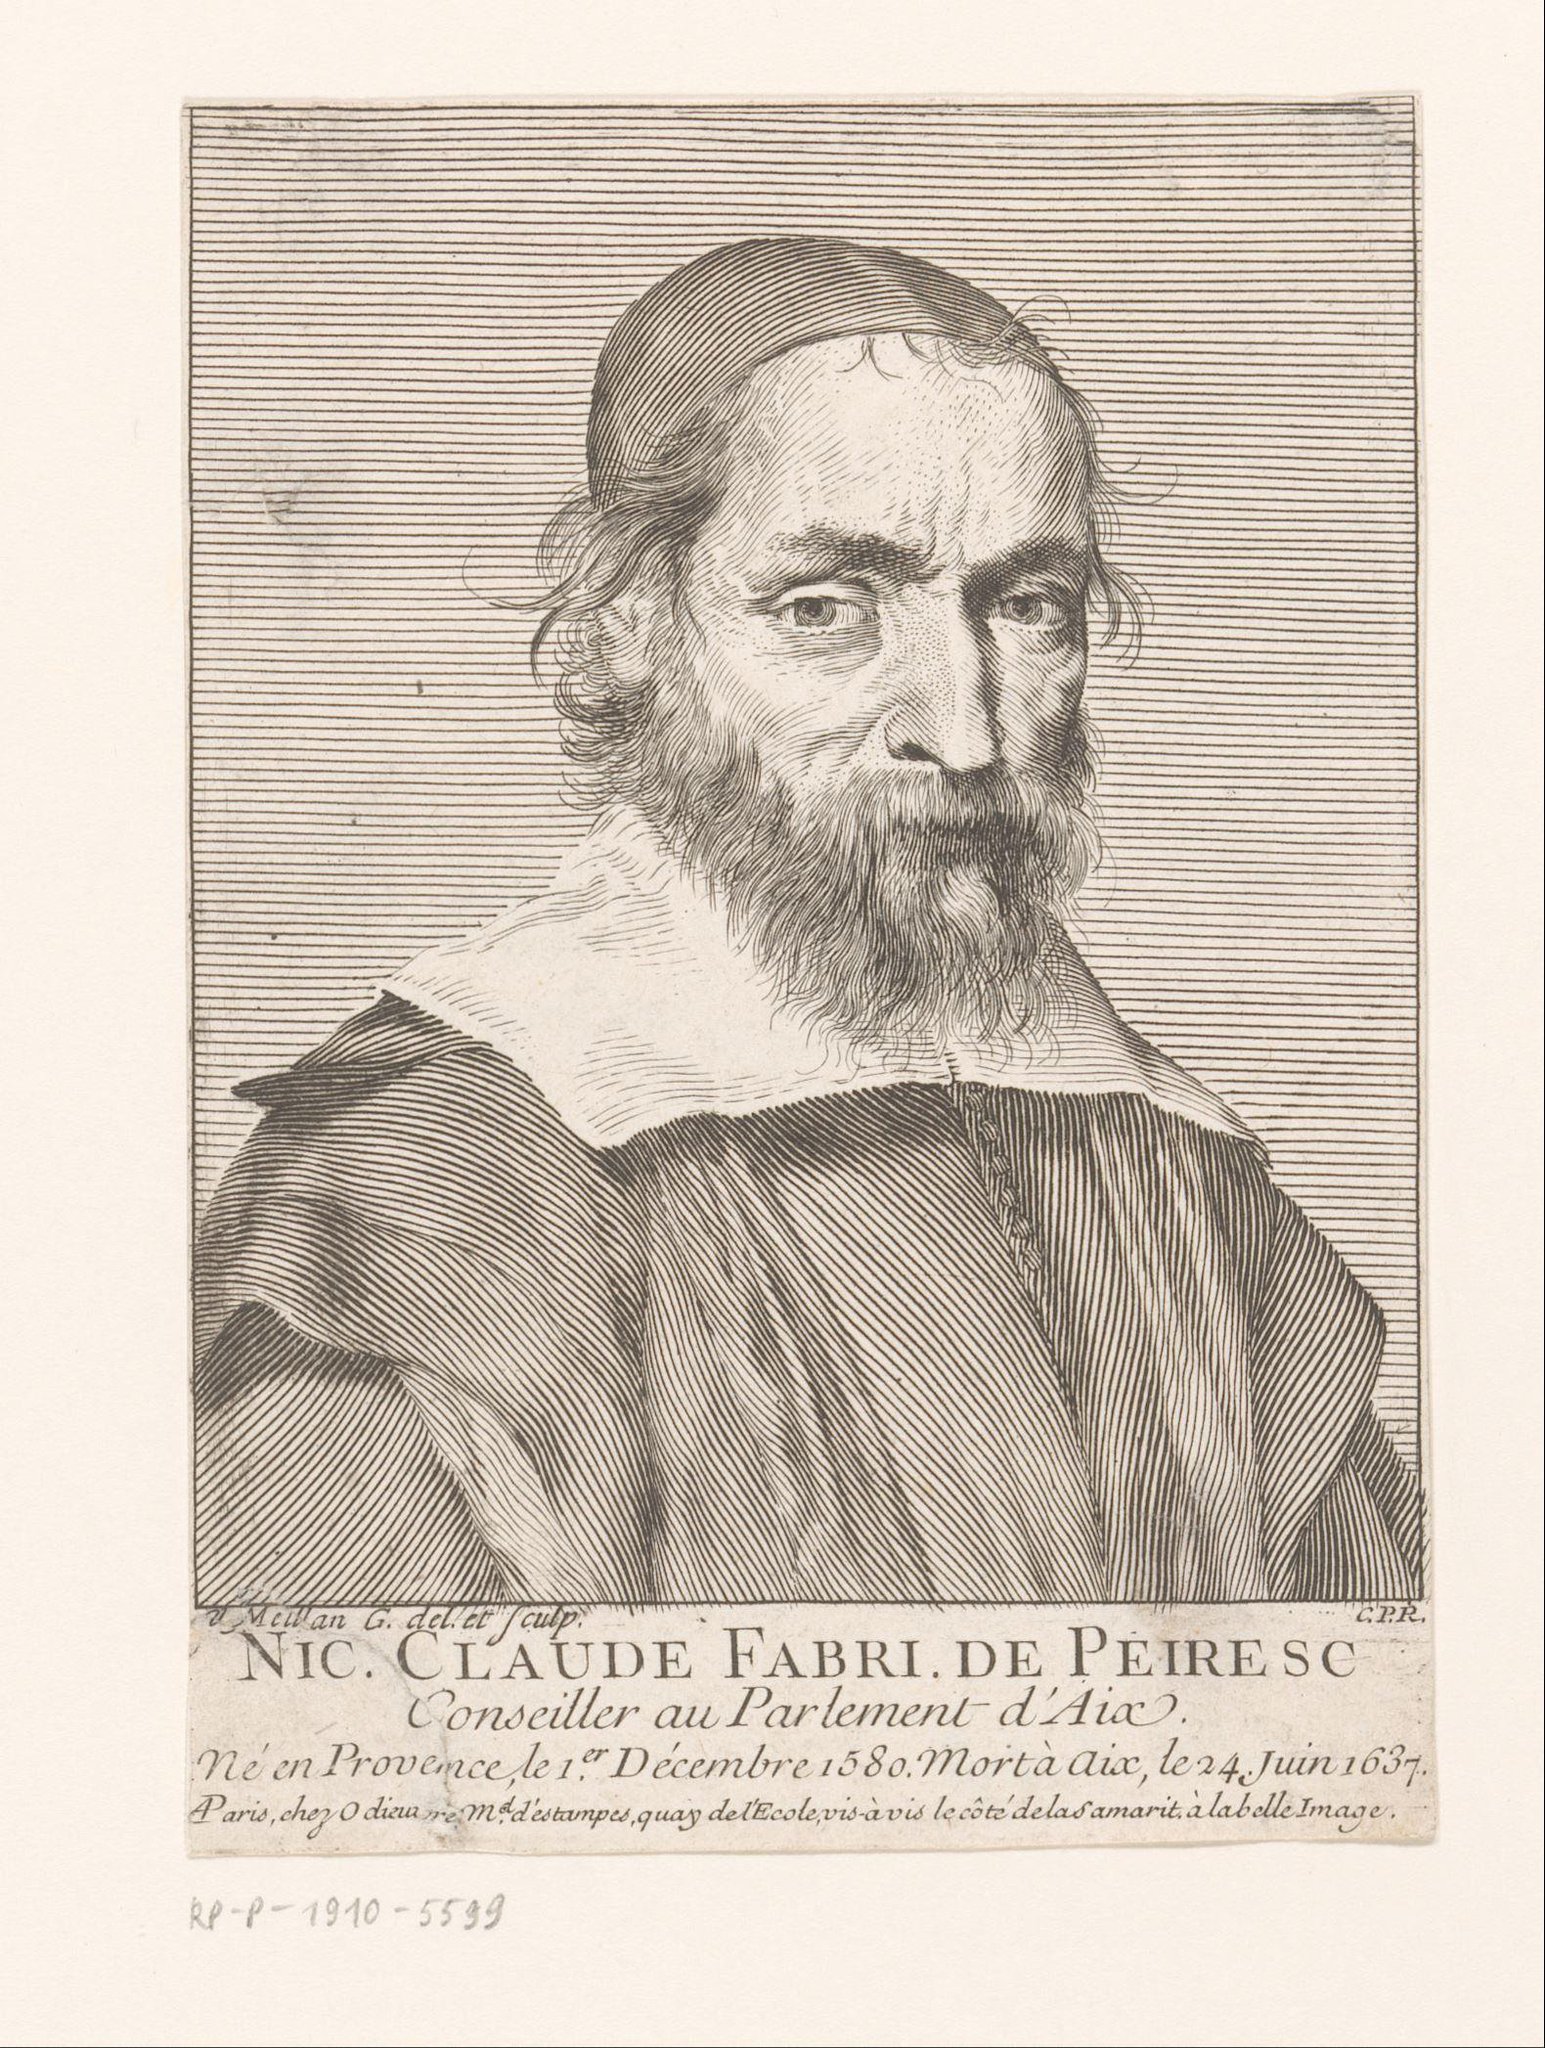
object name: print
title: Portret van Nicolas-Claude Fabri de Peiresc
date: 1755-1765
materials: paper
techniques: engraving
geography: france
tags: nicolas-claude fabri de peiresc, historical persons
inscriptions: collector's mark: Lugt 2228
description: Prent uit: Dreux du Radier, Jean-François. L'Europe illustré, contenant l'histoire abregée des souverains, des princes, des prélats, des ministres, (...) en Europe: dans le XVe. siècle compris, jusqu'à présent. Parijs: Michel Odieuvre en Jean-Luc Nyon, 1755-1765, dl. 5.